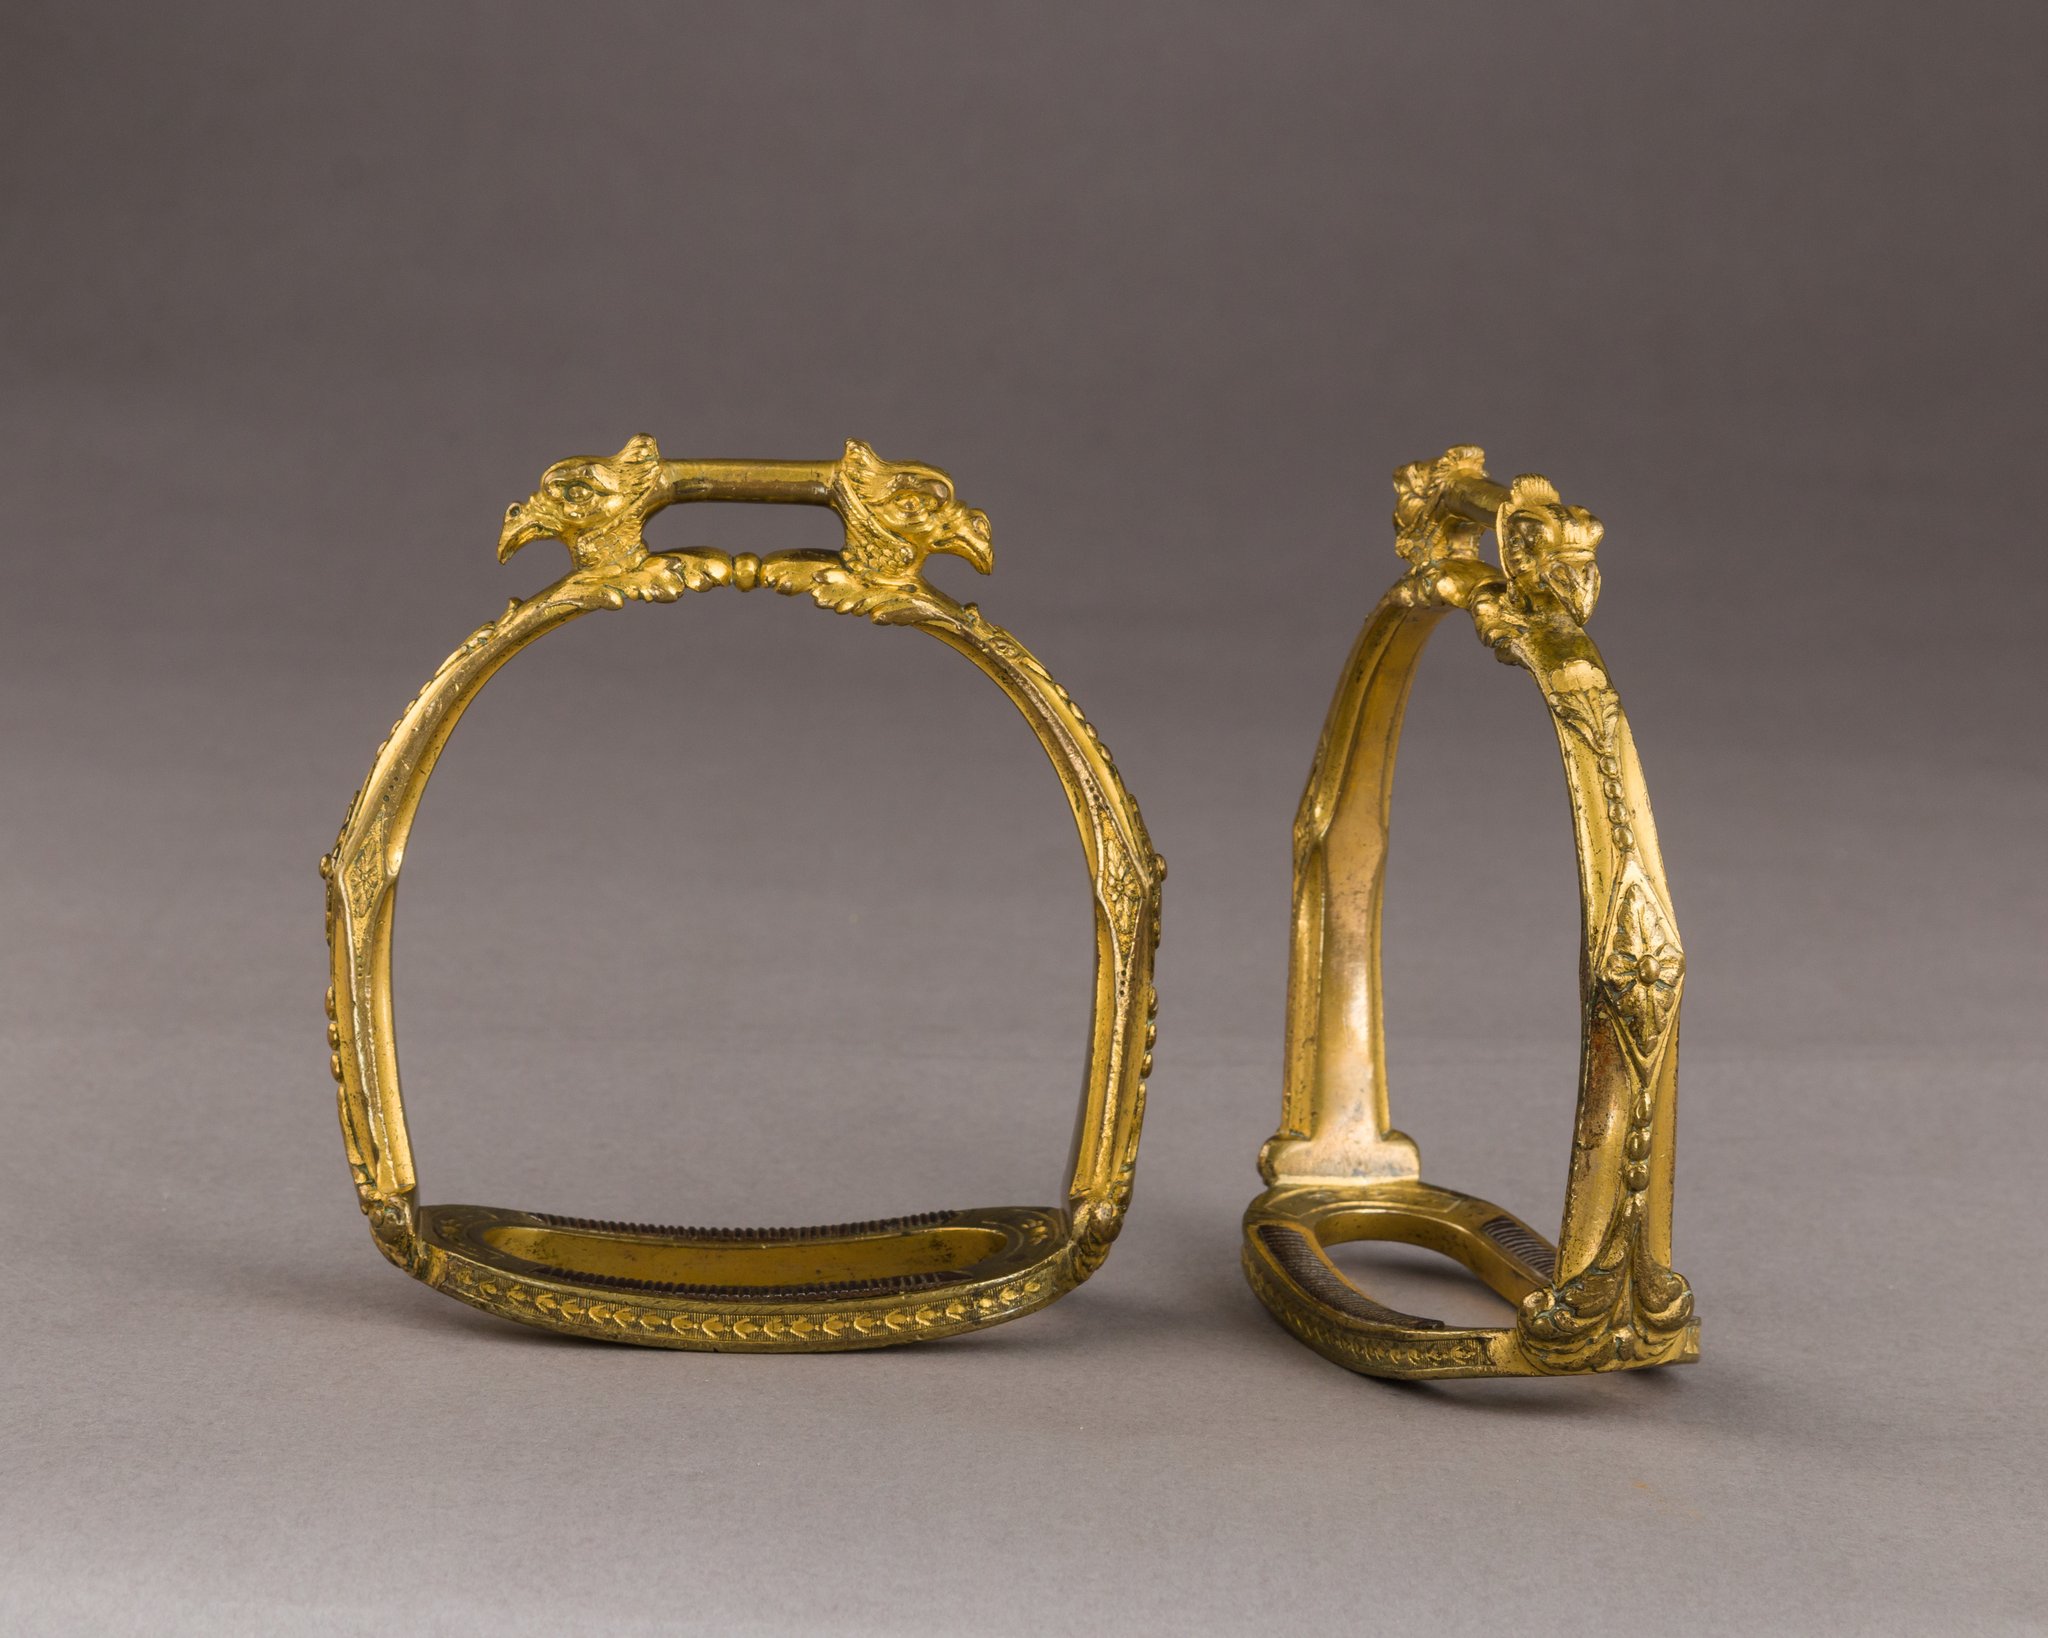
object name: stirrup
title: Pair of Stirrups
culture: french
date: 1801-1833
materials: copper alloy, gold, iron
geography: france